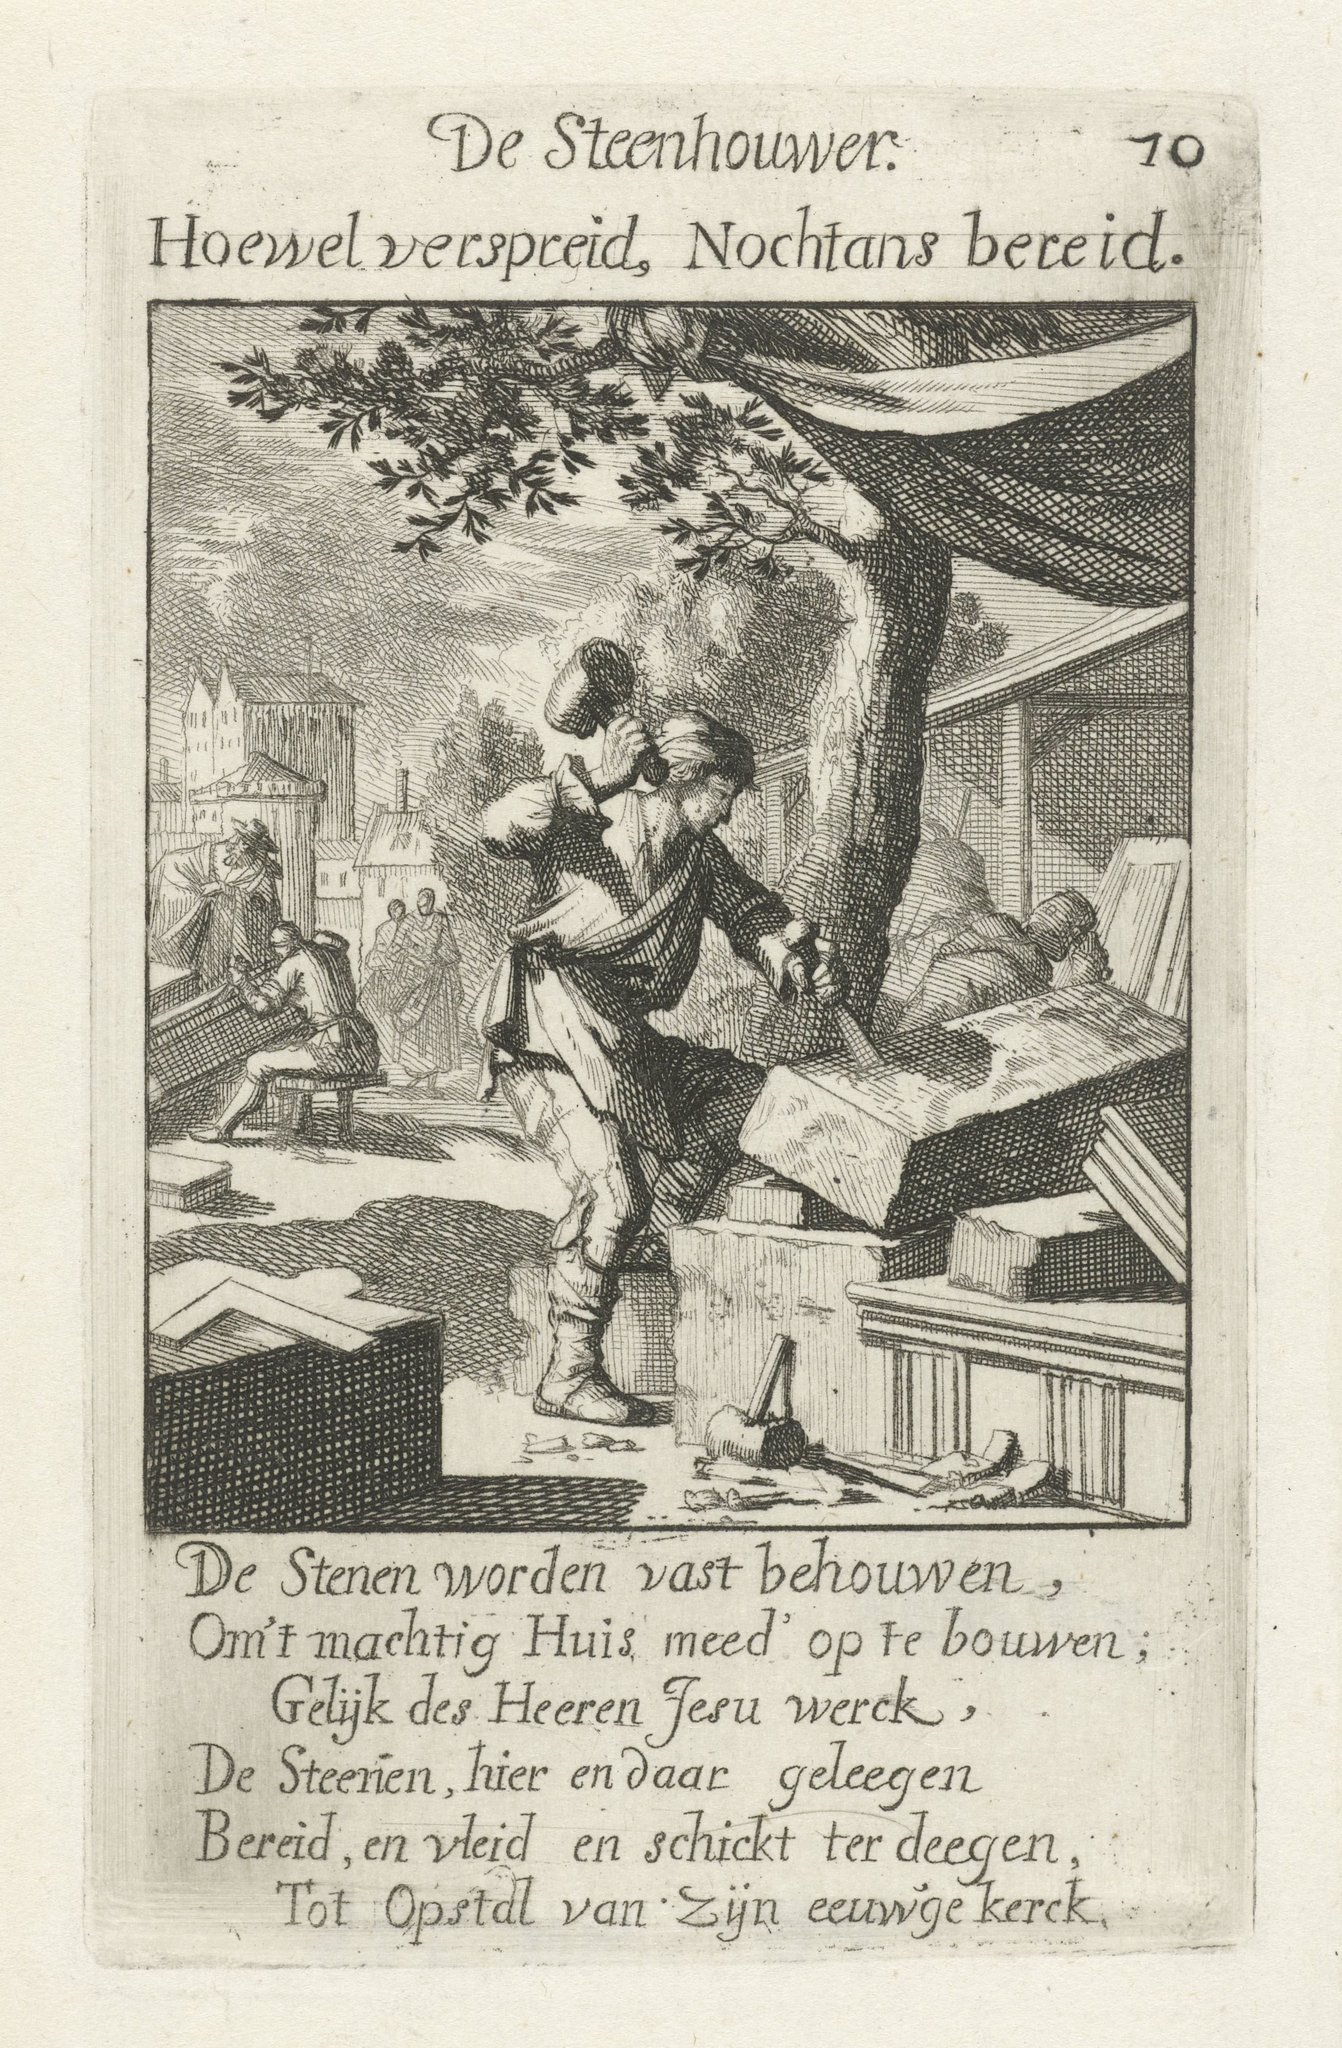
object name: print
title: De Steenhouwer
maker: jan luyken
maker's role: draughtsman, print maker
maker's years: 1649-1712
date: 1694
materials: paper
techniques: etching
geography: amsterdam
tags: stone-cutter, stone-sawyer, handicrafts, craftsman at work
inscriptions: collector's mark: Lugt 2228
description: Maakt deel uit van de 100-delige serie beroepsprenten van Jan en Caspar Luyken, getiteld: Het menselyk bedryf. S.l.s.n., 1694 (eerste druk).